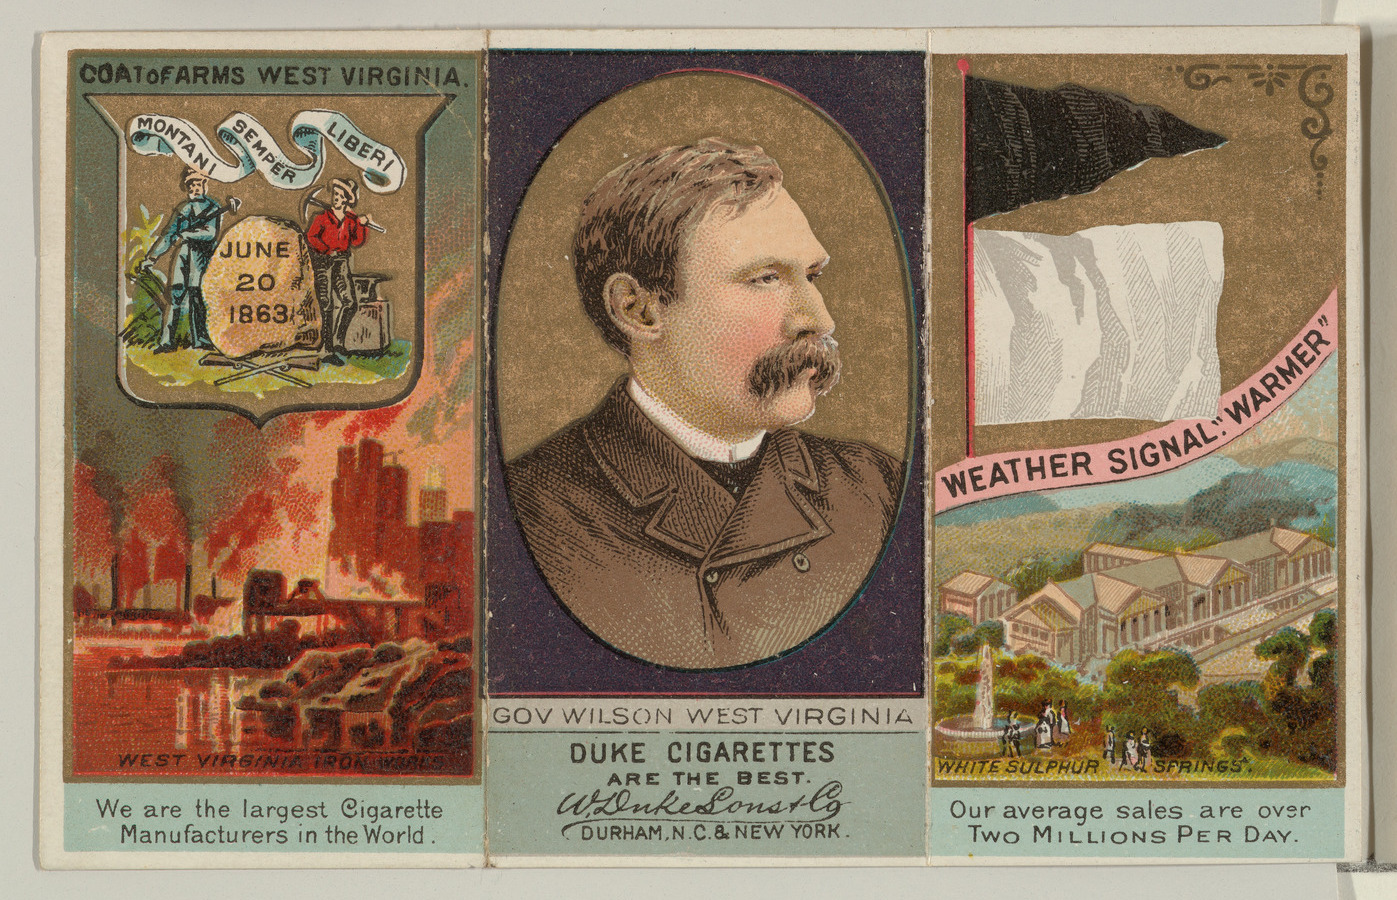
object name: print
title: Governor Wilson, West Virginia, from "Governors, Arms, Etc." series (N133-2), issued by Duke Sons & Co.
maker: w. duke, sons & co.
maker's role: publisher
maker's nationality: american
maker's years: 1870-1920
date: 1888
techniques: color lithograph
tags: buildings,men,profiles,coat of arms,flags